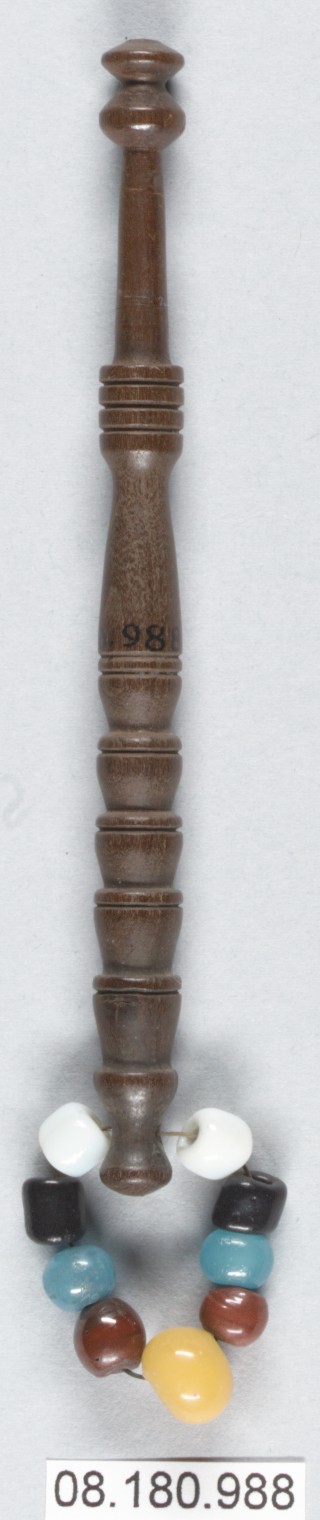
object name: bobbin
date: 1801-1900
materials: wood